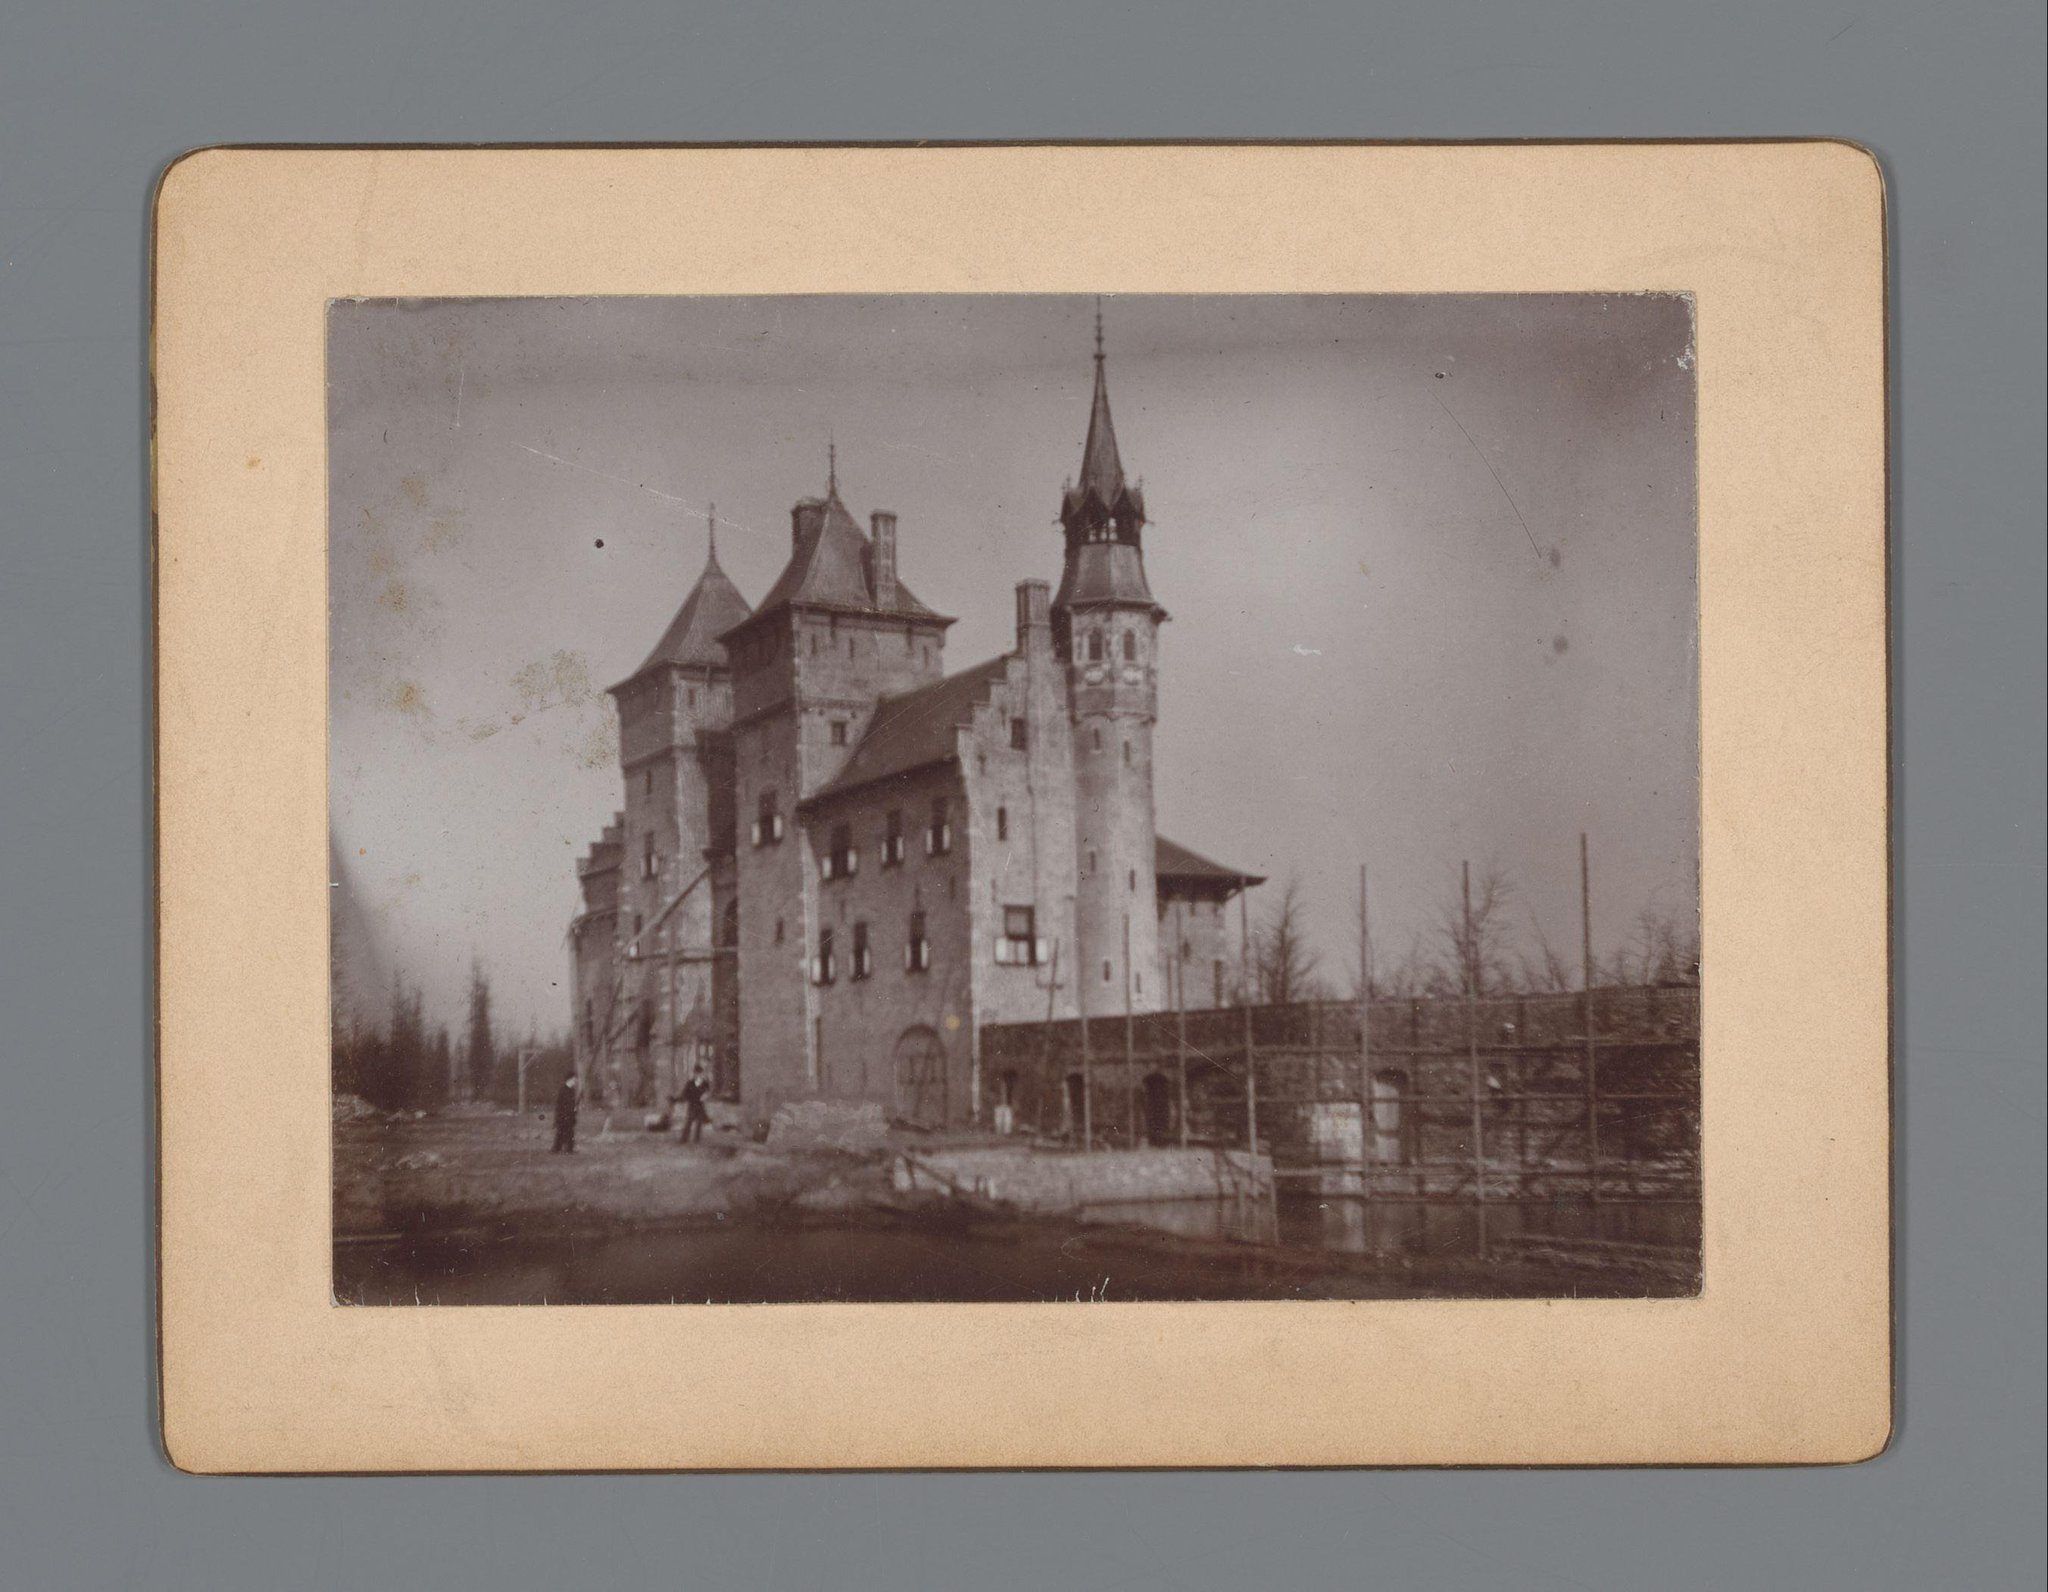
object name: photograph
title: Kasteel de Haar te Haarzuilens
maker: Anonymous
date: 1880-1910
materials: cardboard, photographic support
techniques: collodion silver print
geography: haarzuilens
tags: landscape with tower or castle